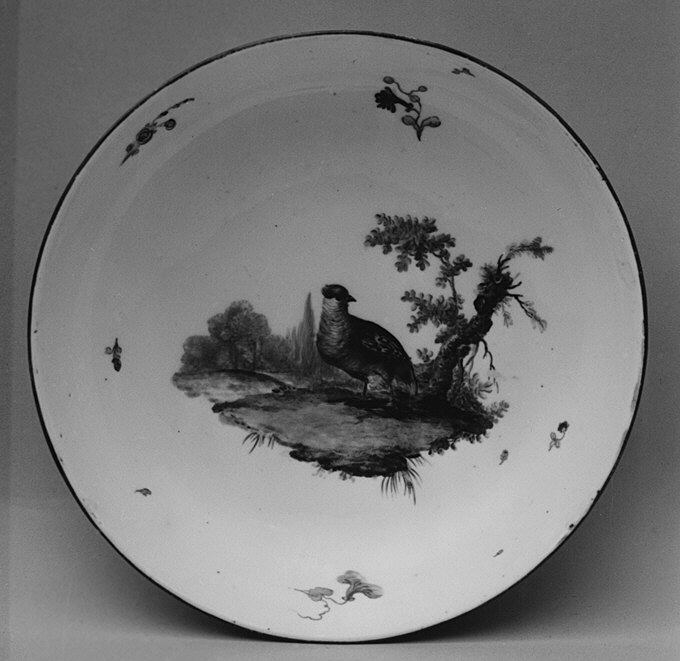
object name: saucer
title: Saucer (part of a service)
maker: frankenthal porcelain manufactory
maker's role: manufactory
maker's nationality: german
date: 1770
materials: hard paste porcelain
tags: birds,trees